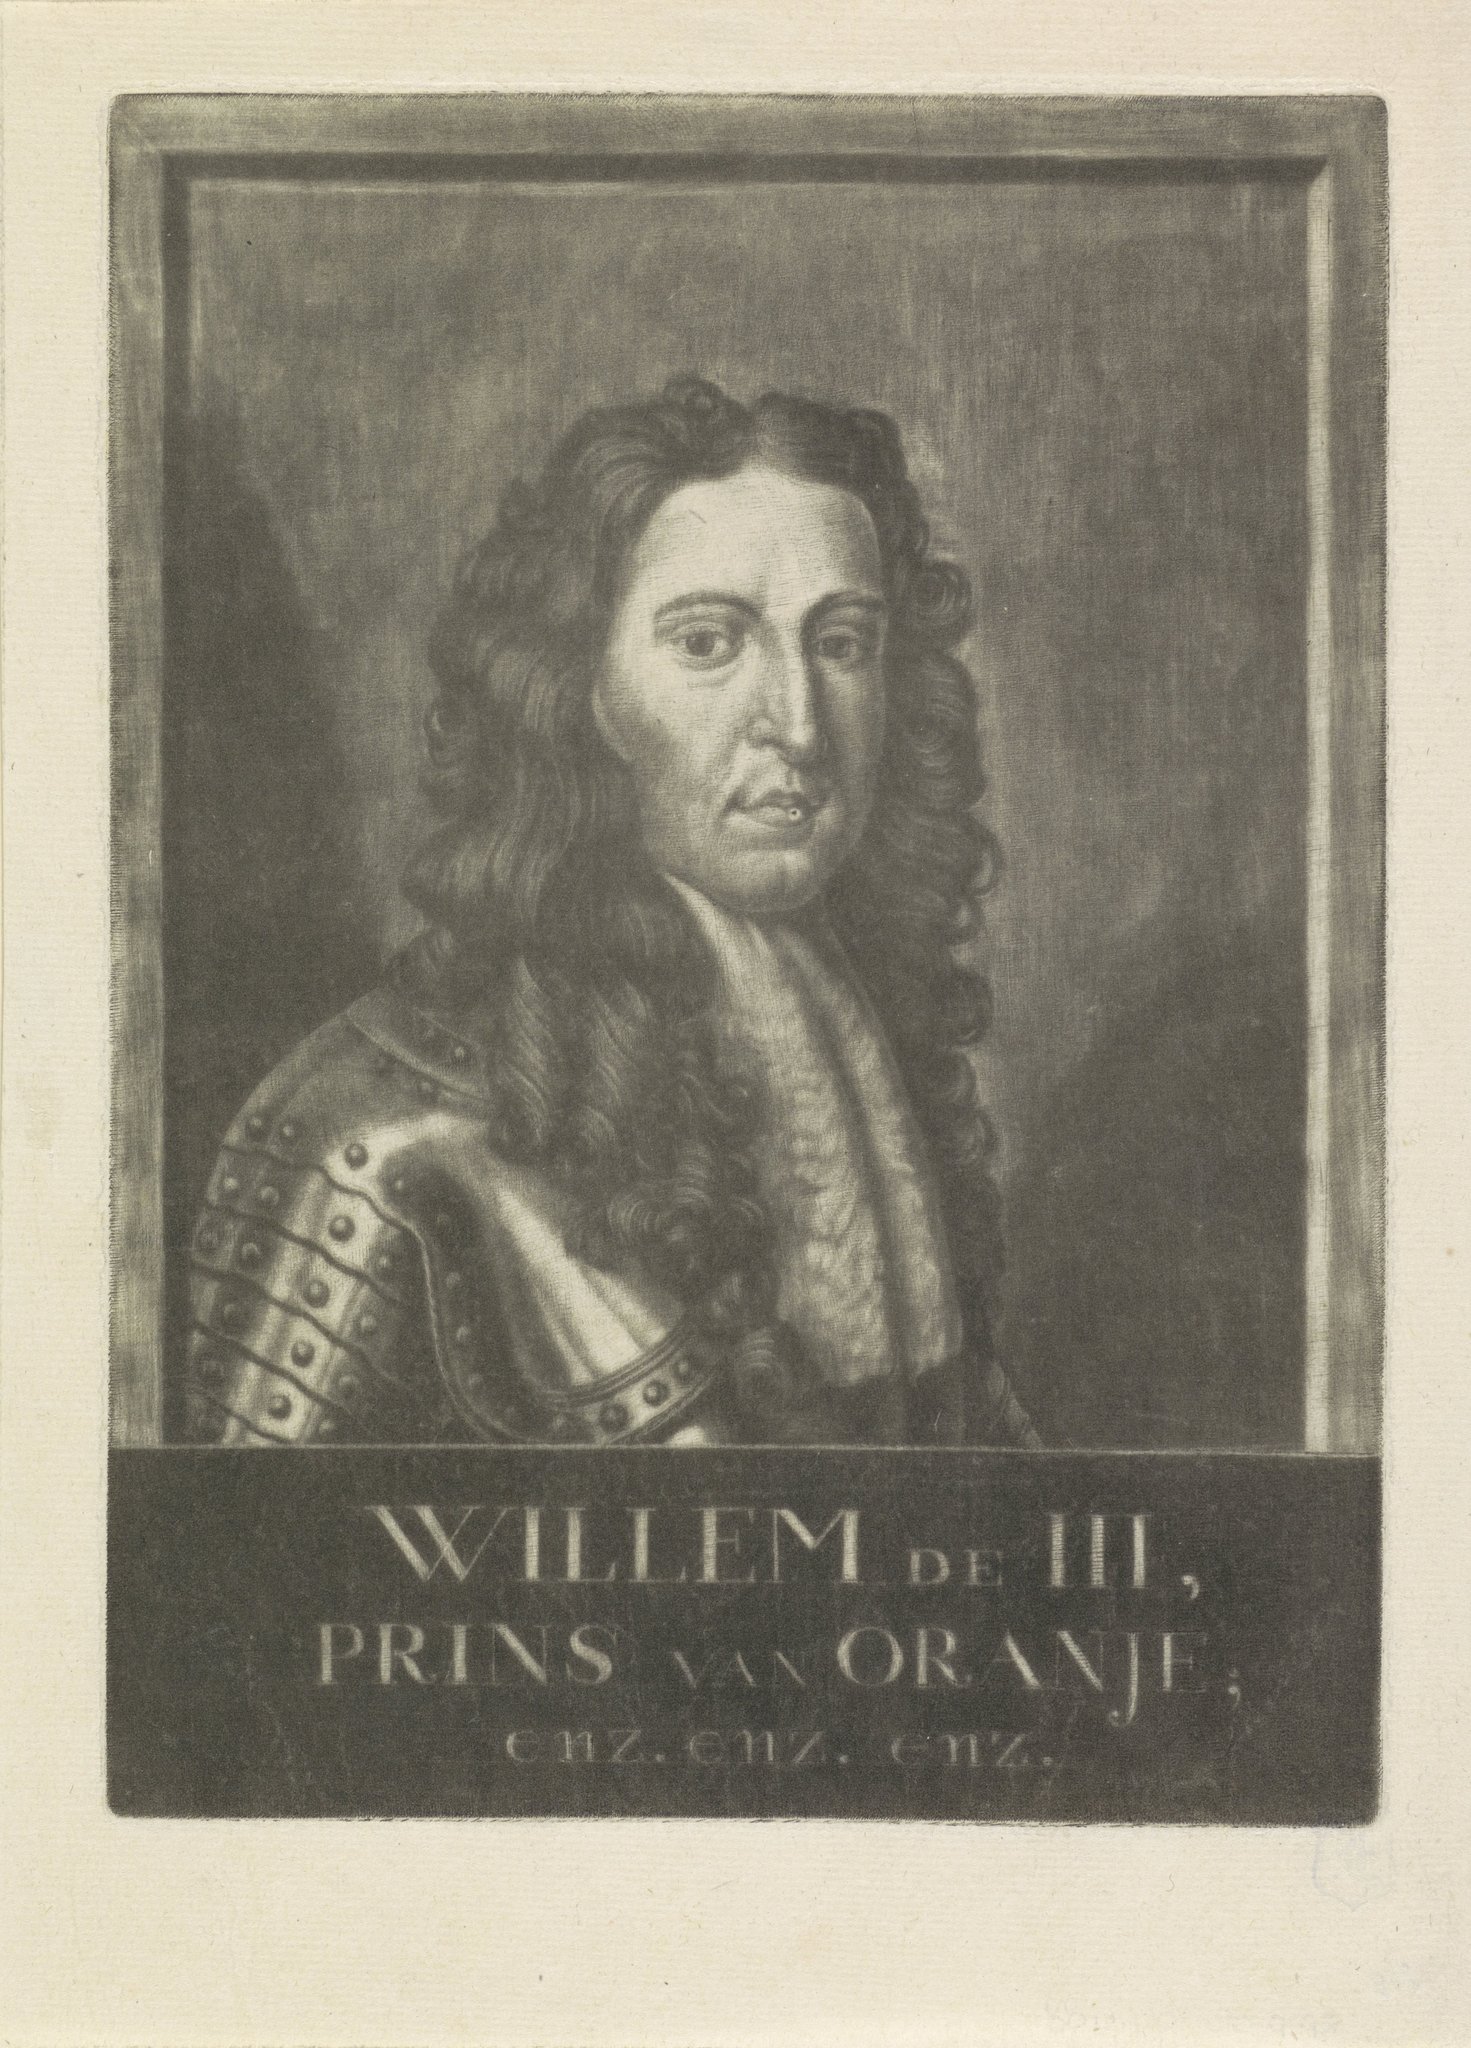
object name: book illustration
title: Portret van Willem III, prins van Oranje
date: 1770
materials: paper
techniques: mezzotint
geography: leeuwarden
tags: william iii (prince of orange and king of england, scotland, and ireland)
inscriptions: collector's mark: Lugt 963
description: De hier vermelde titel verwijst naar de hoogst verkregen titel van de geportretteerde, niet per se naar de titel die de geportretteerde op deze voorstelling draagt. Prent uit: Bosch, Johannes van den. De heeren stadhouderen van Vriesland, zedert den jare acht-hondert, volgens hoogst derzelver successie kortelyk beschreven. Leeuwarden: Abraham Ferwerda en Gerrit Tresling, 1770.